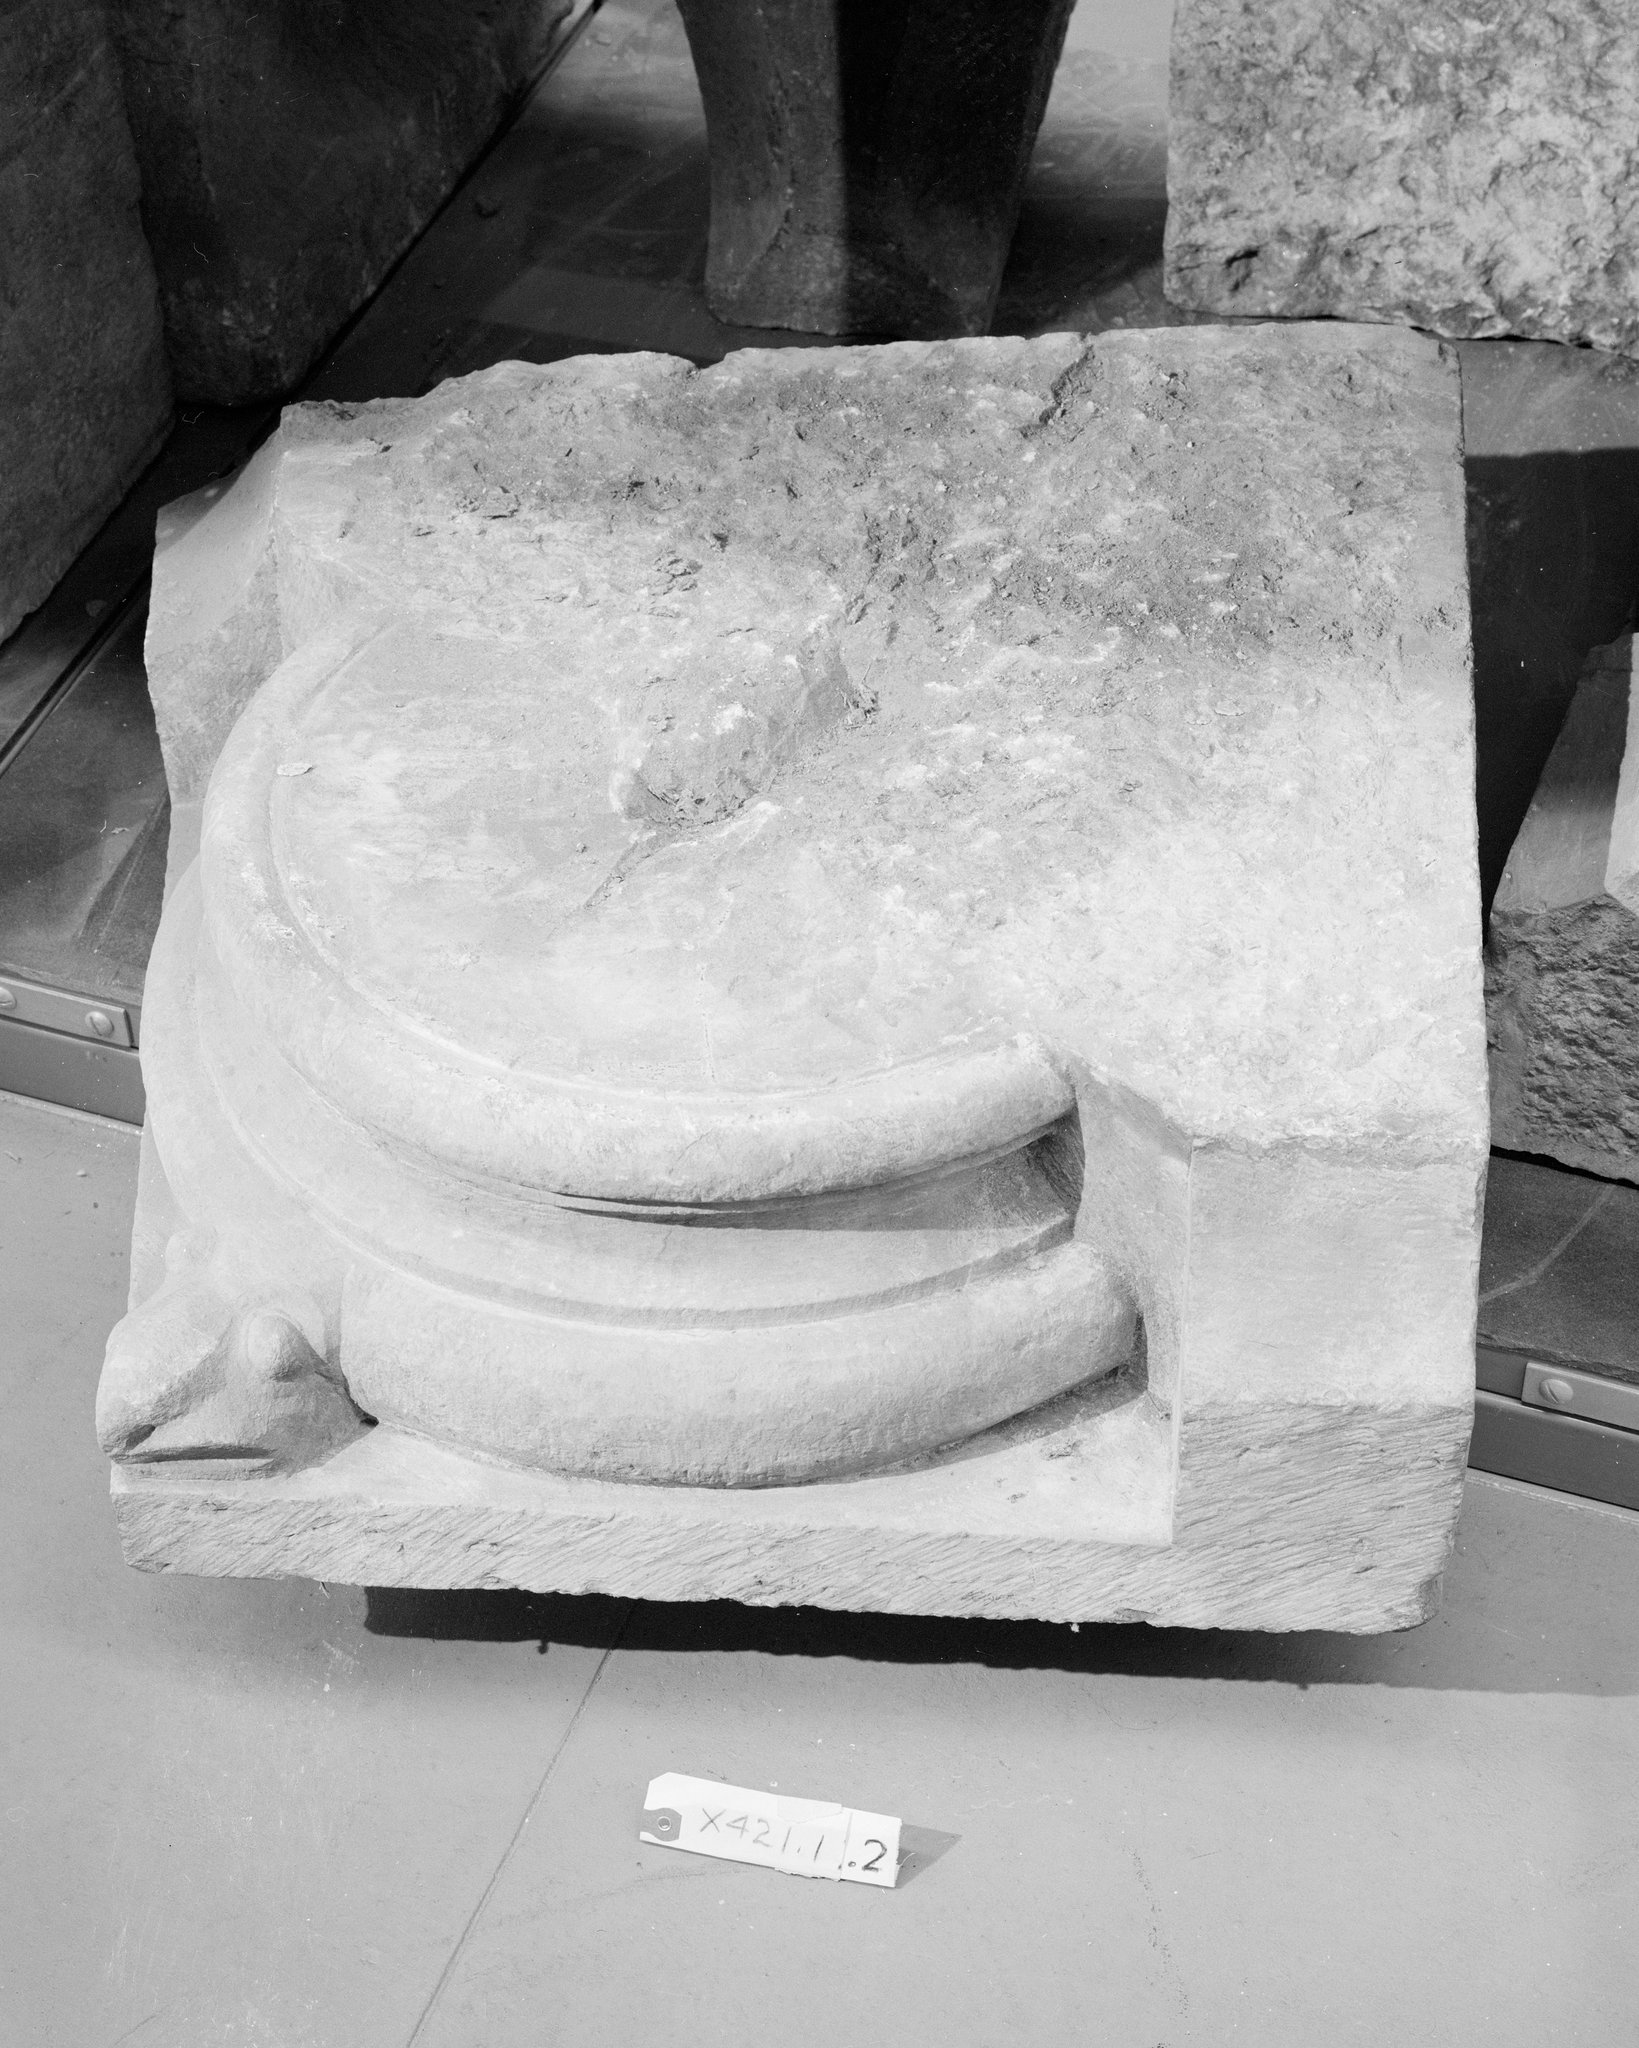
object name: base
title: Base, Engaged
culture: french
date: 1130-1140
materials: stone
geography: france